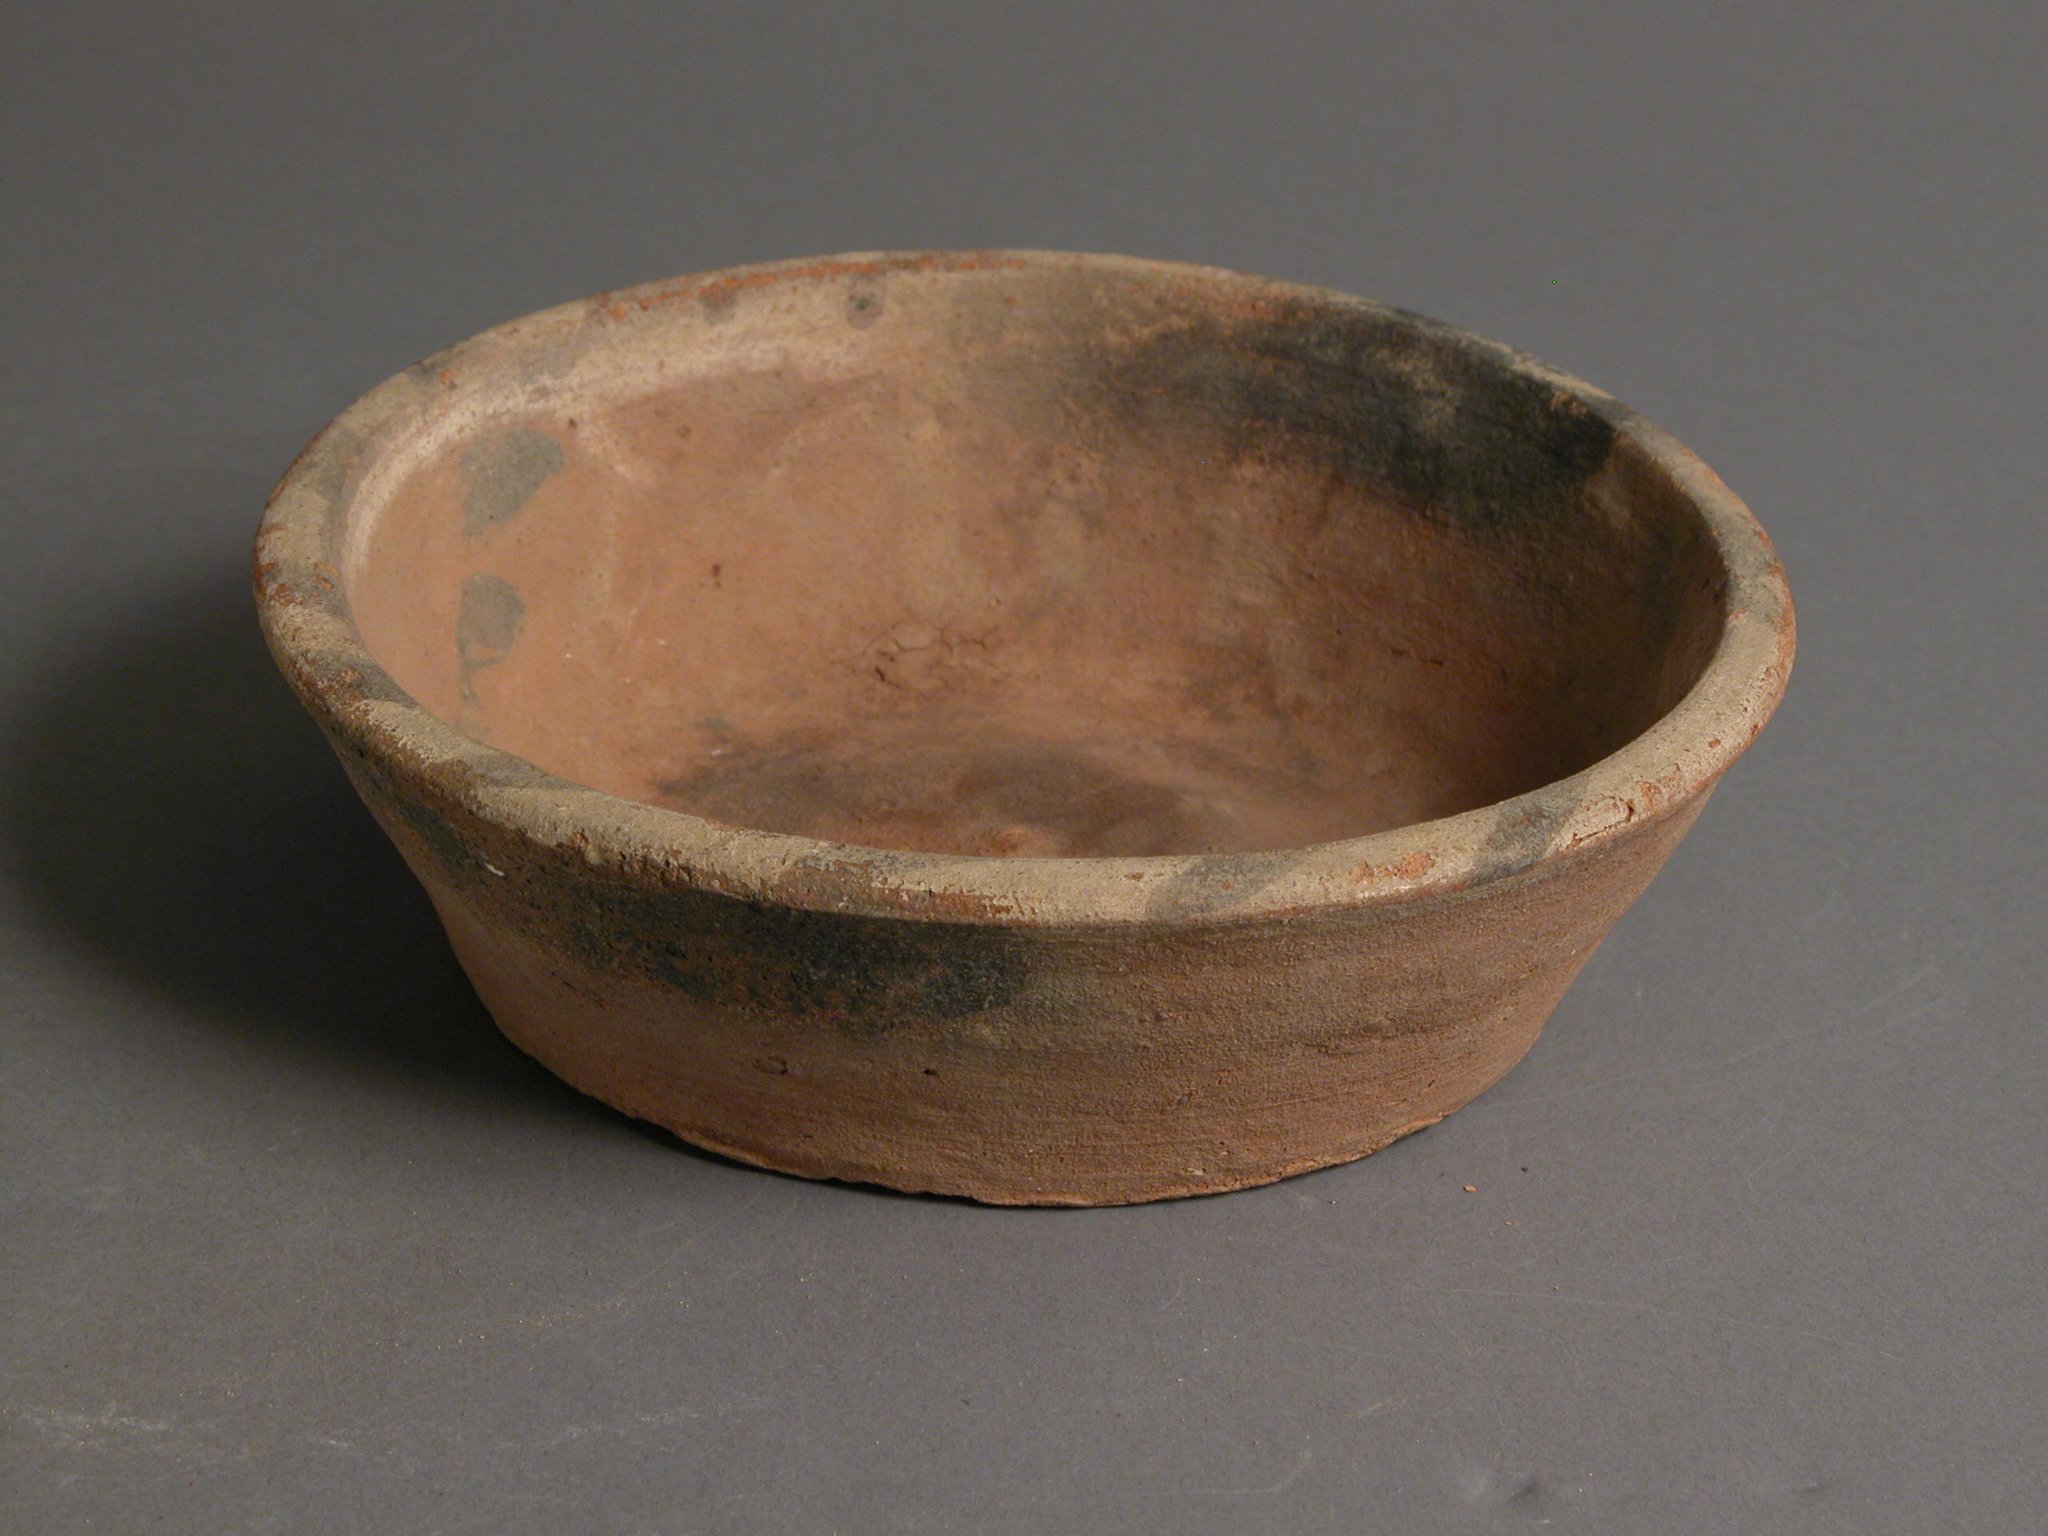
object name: bowl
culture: coptic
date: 301-700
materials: earthenware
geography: egypt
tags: bowls